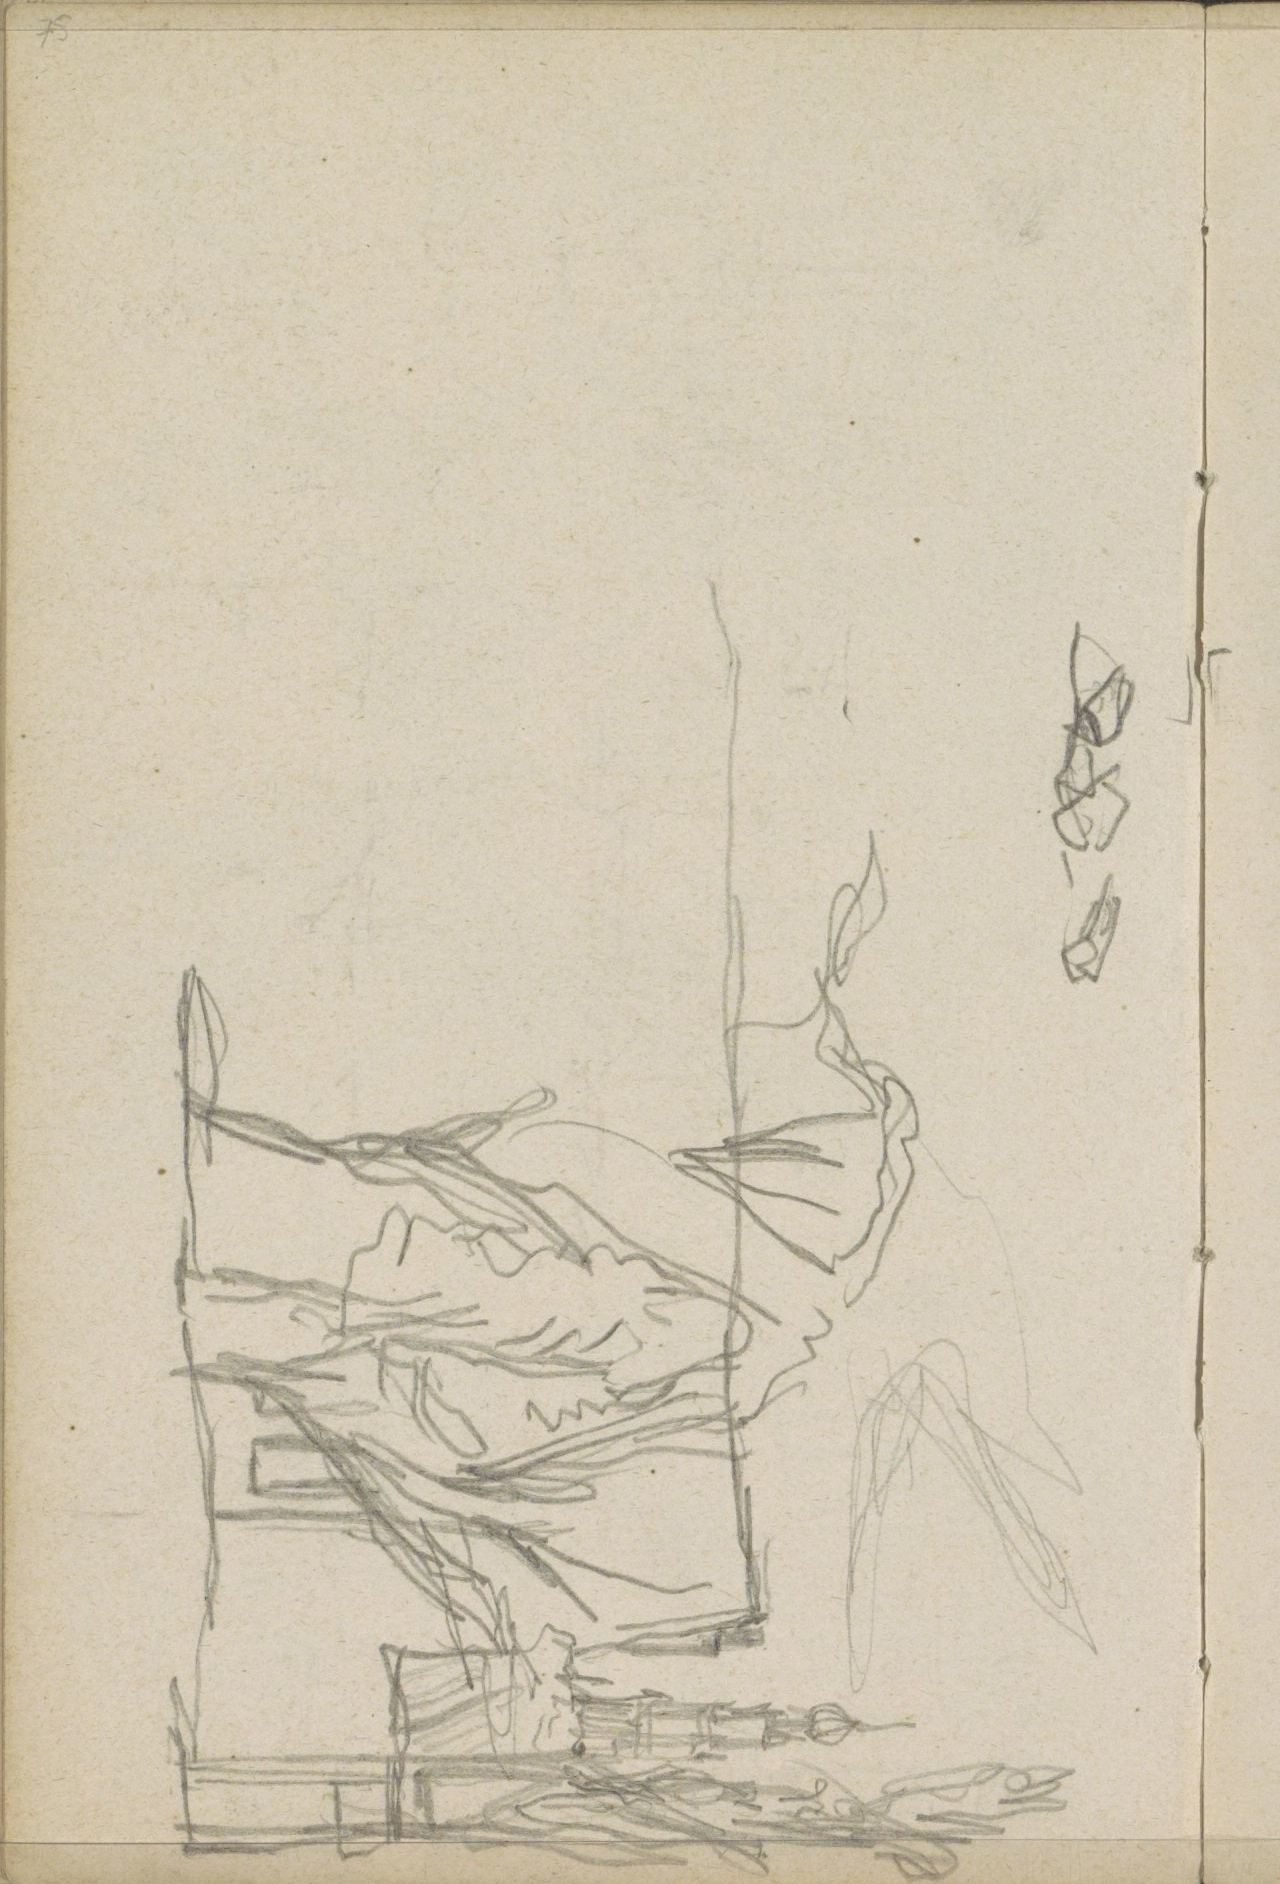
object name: sketchbook leaf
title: Gezicht in Haarlem met de Sint-Bavokerk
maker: george hendrik breitner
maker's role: draughtsman, painter, print maker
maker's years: 1857-1923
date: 1902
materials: paper, pencil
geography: haarlem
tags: urban housing, church (exterior)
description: Pagina 75 uit een schetsboek met 46 bladen vervaardigd in de omgeving van Amsterdam, Rotterdam en Haarlem.